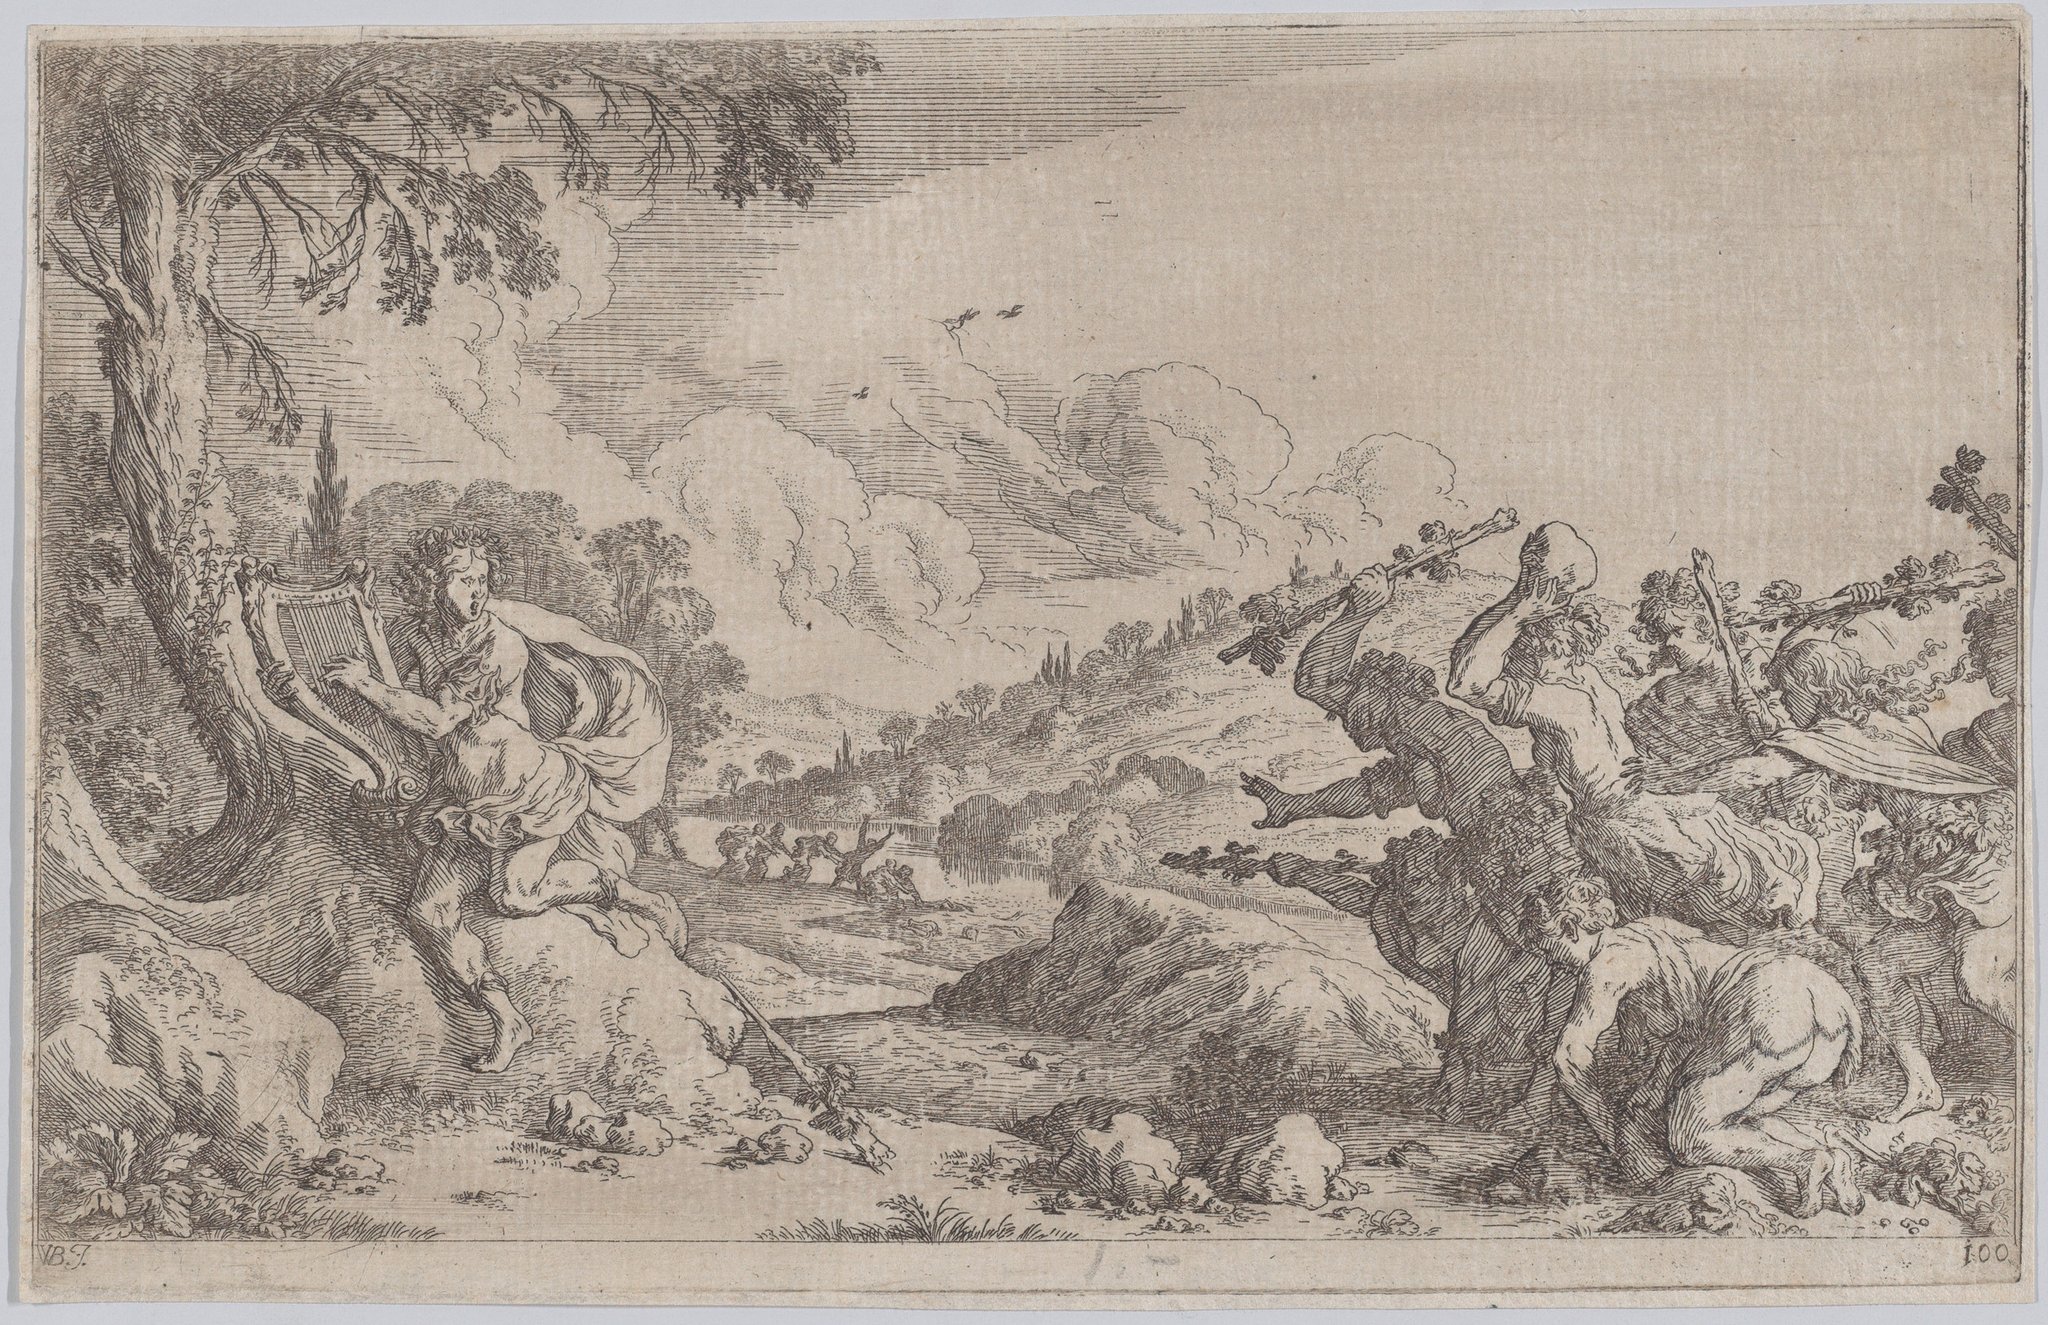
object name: print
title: Plate 100: The death of Orpheus, from "Ovid's Metamorphoses"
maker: johann wilhelm baur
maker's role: artist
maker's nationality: german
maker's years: 1607-1642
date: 1641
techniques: etching